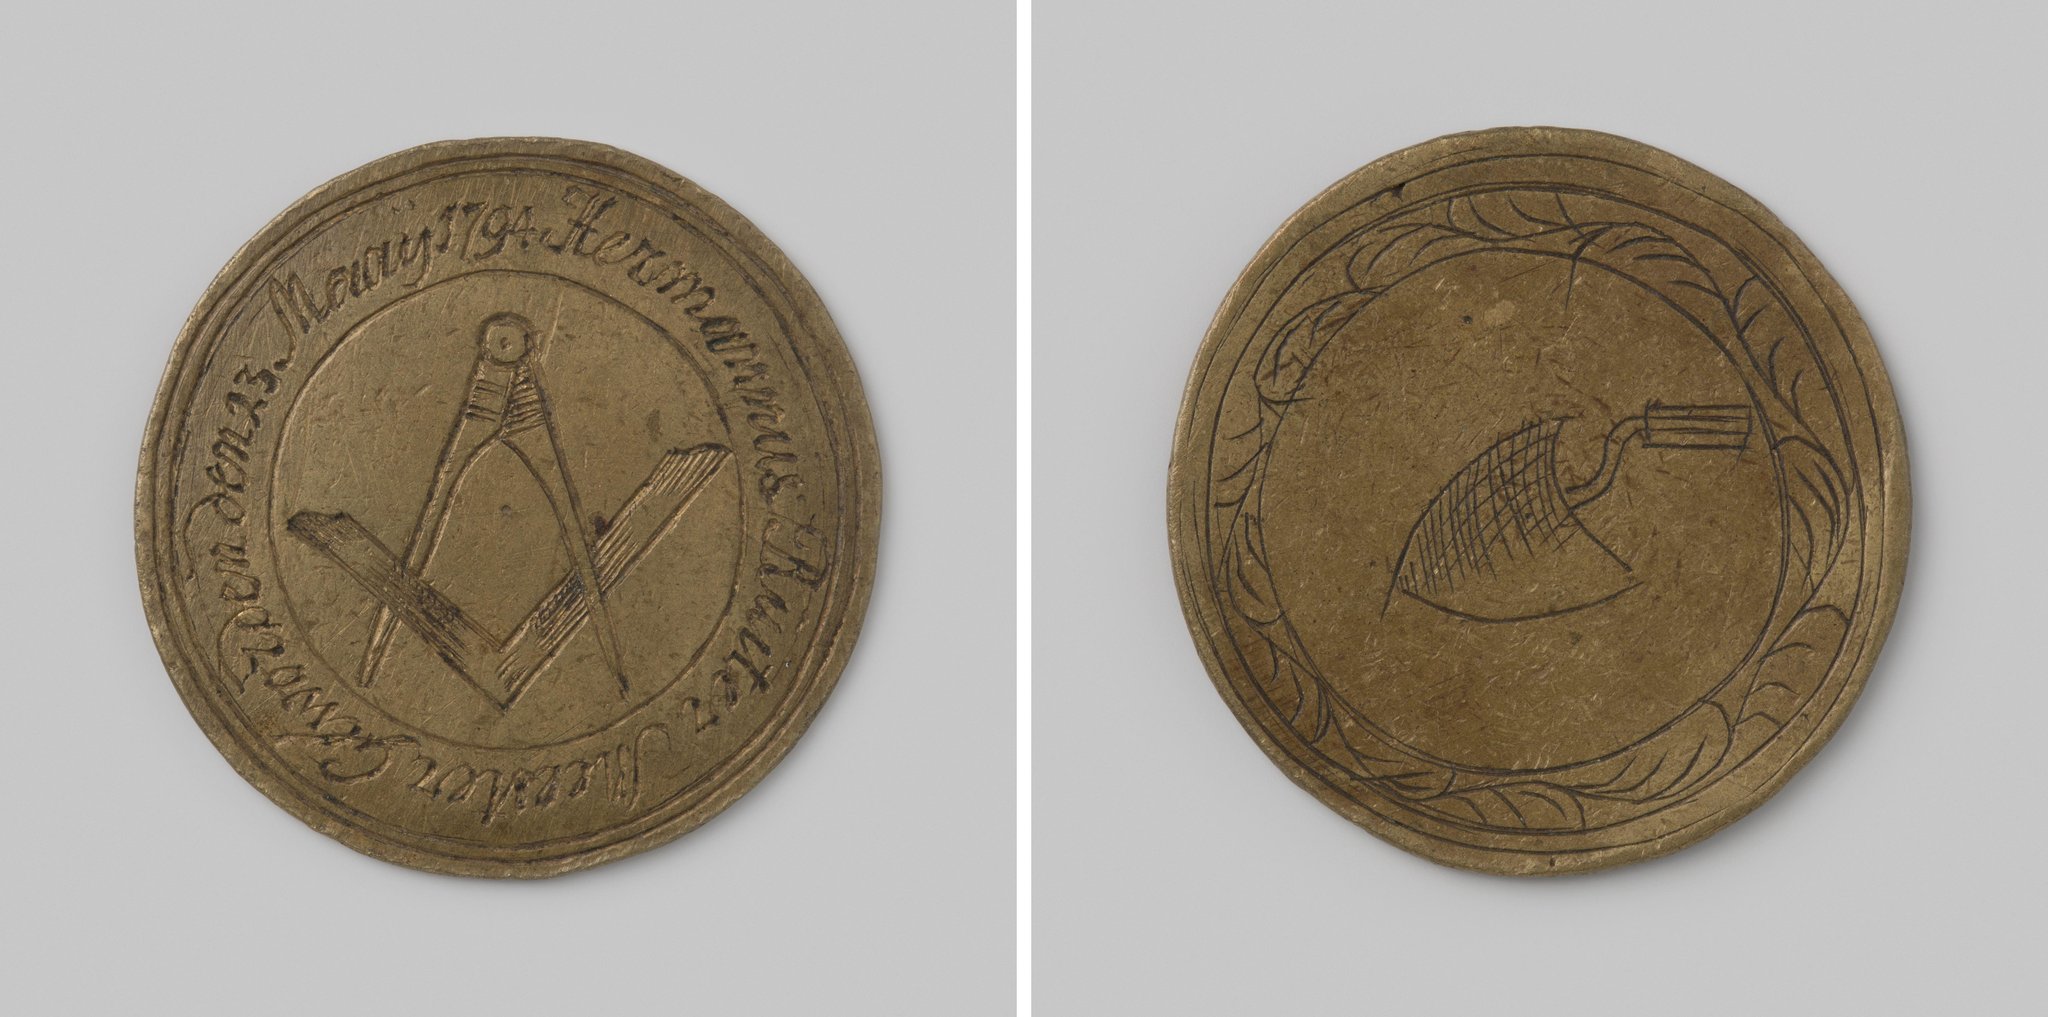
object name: history medal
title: Presentiepenning van het Metselaars-, timmerlieden- en leidekkersgilde te Groningen, 1759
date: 1759-1794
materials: brass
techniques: engraving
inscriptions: circumscription: ‘Hermannus Ruiter Meester Geworden den 23 Maaij 1794’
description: Rond messing plaatje gegraveerd op de voorzijde een passer en een winkelhaak met omschrift, op de keerzijde een troffel binnen een rand met bladmotieven, op naam van Hermannus Ruiter 1794